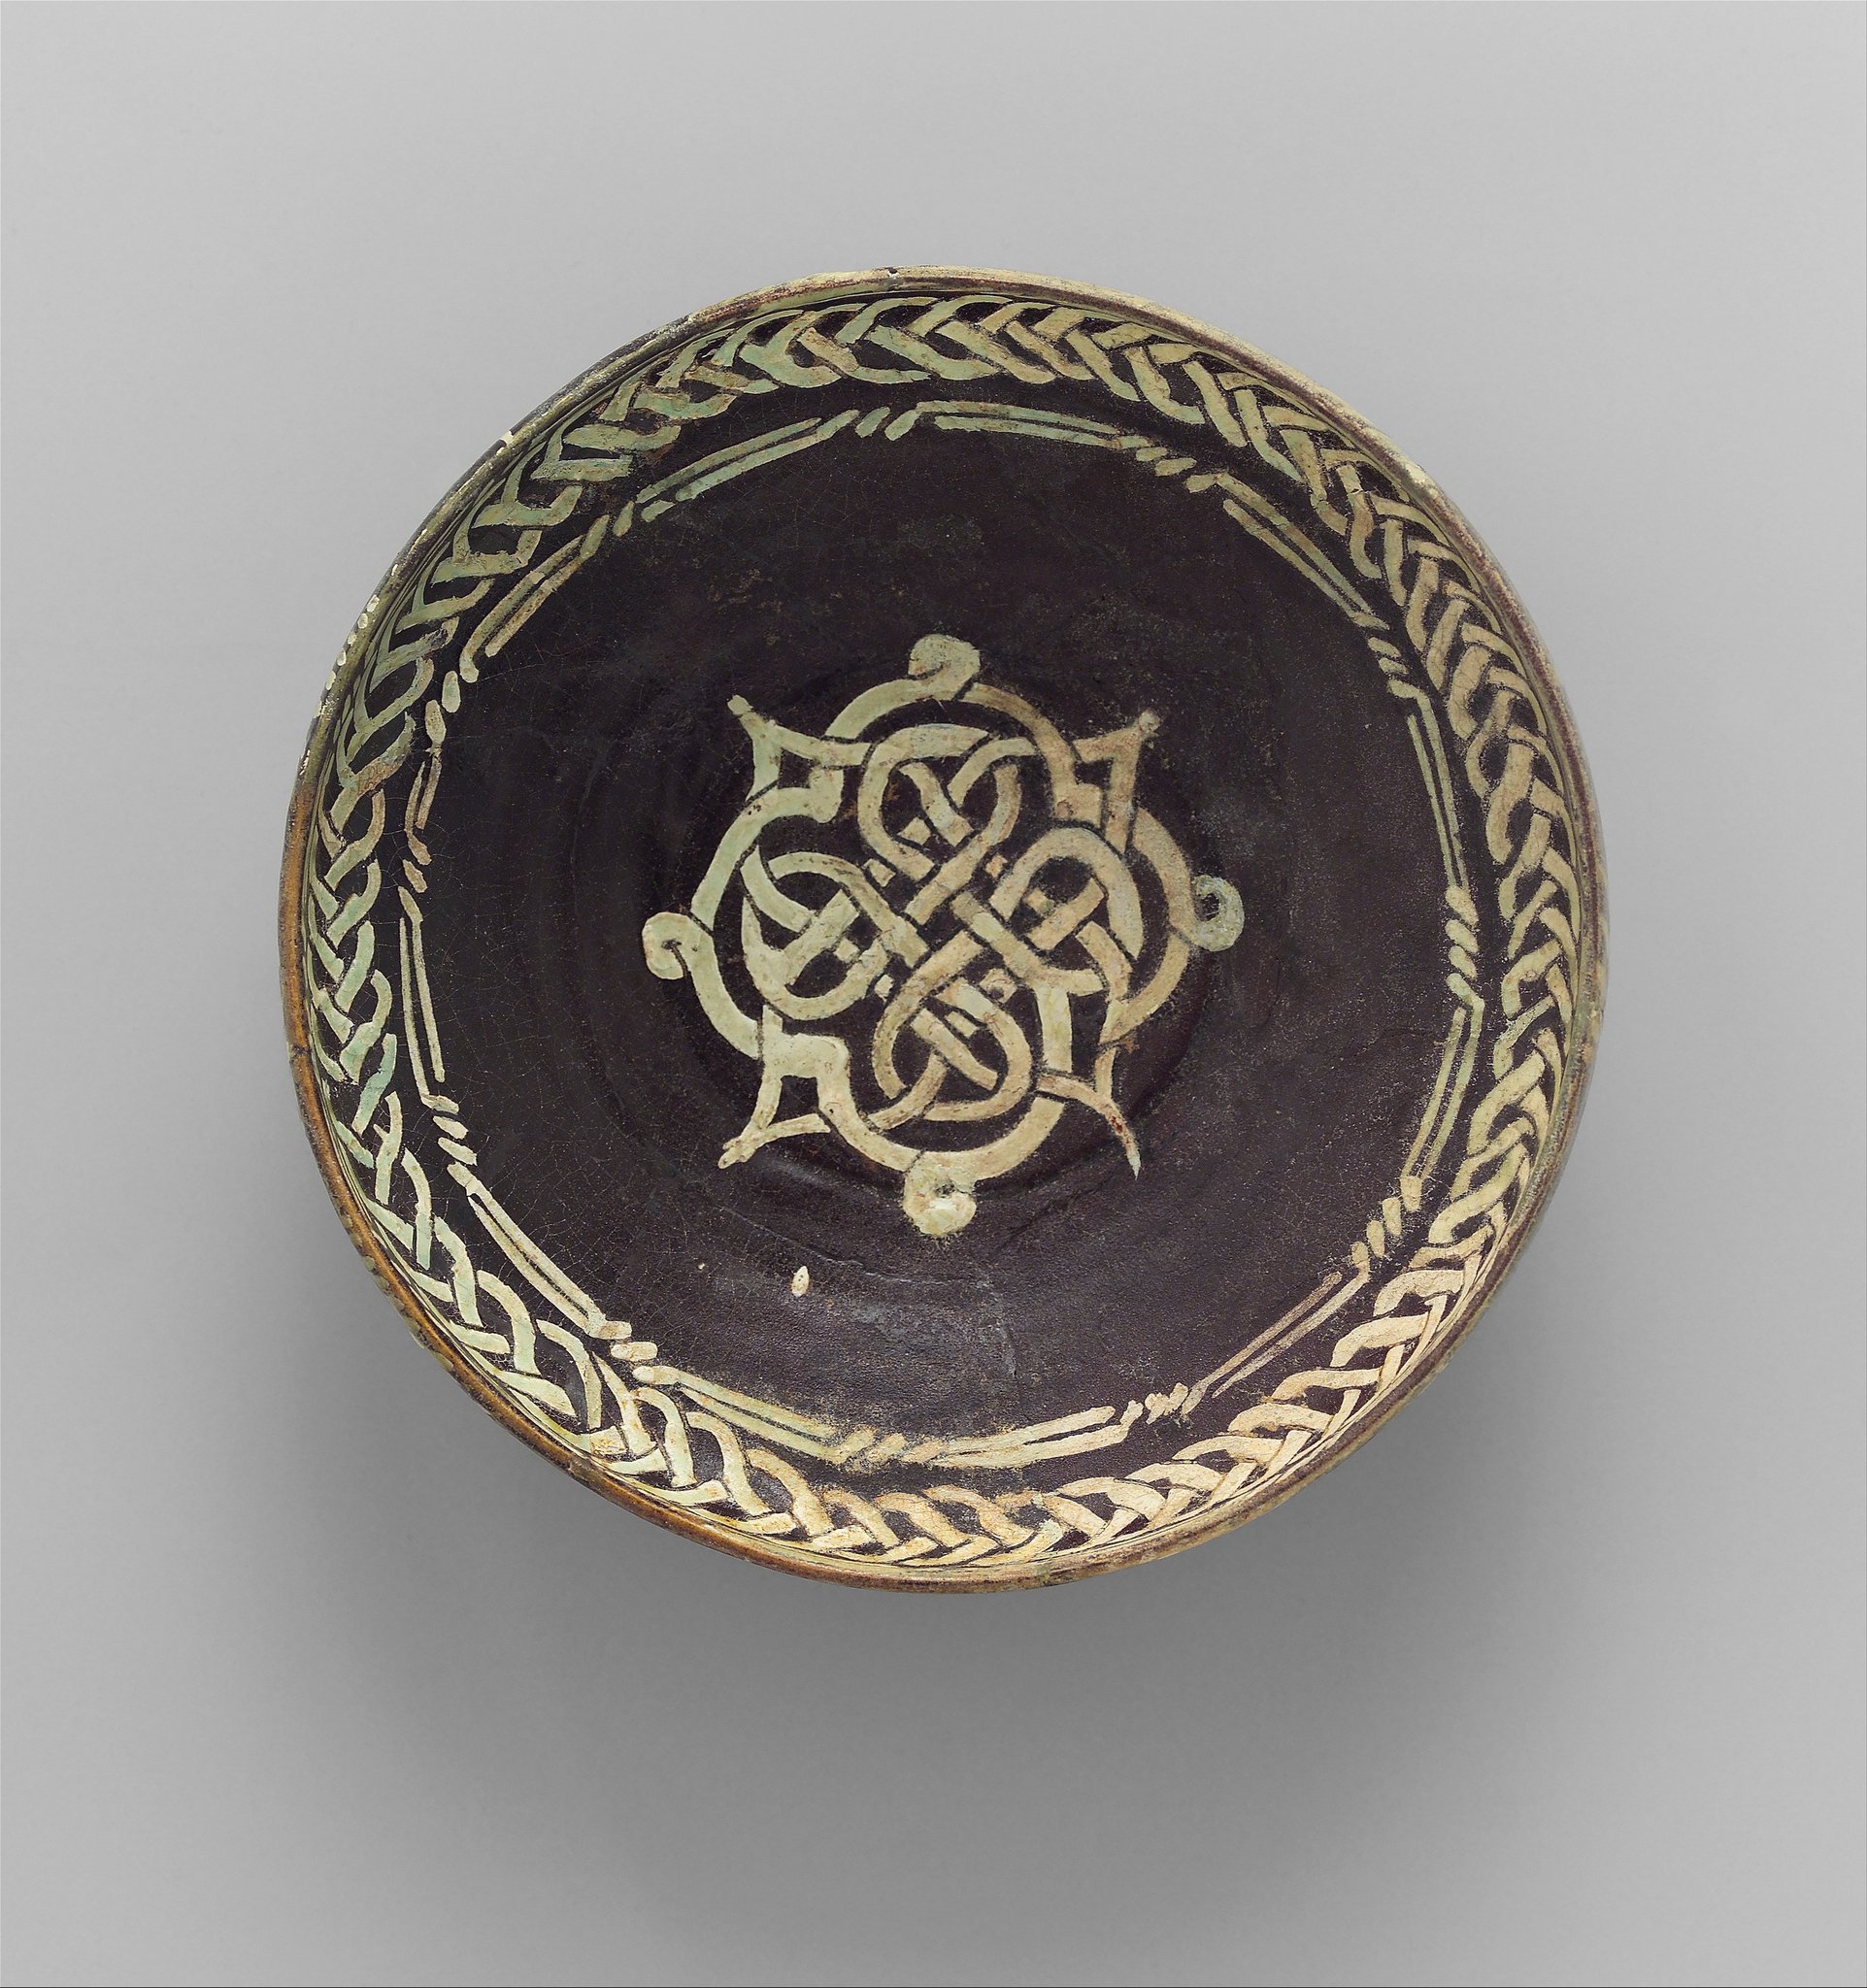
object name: bowl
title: Bowl with Knotted Medallion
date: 901-1000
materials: earthenware, glaze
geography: iran